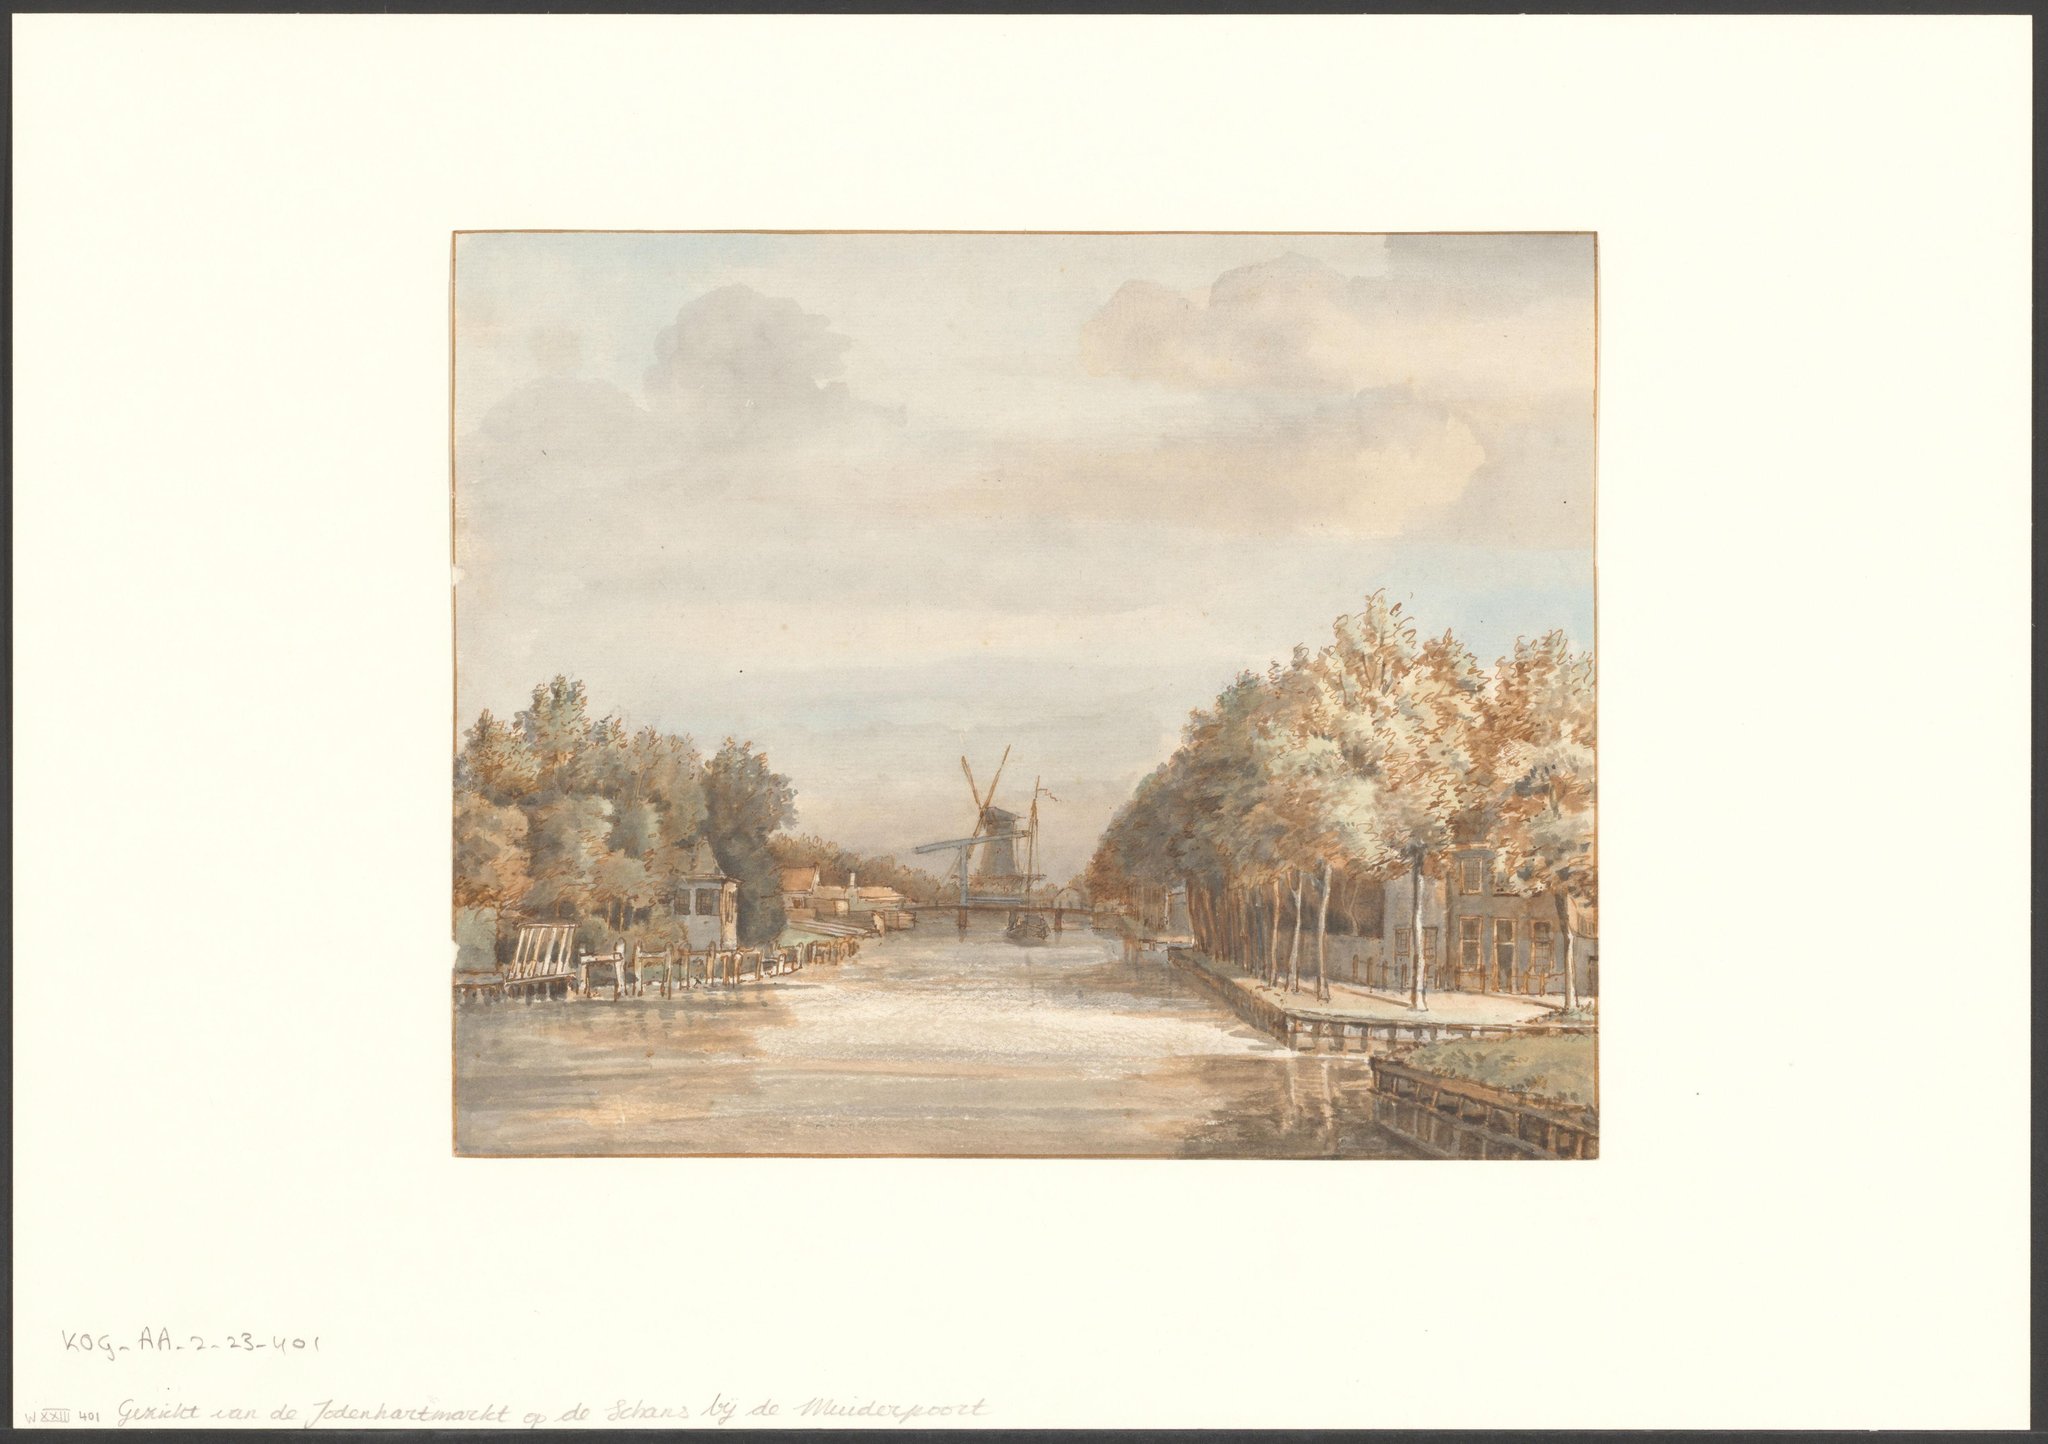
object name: drawing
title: Gezicht op de Jodenhoutmarkt op de schans bij de Muiderpoort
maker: gerrit lamberts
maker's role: bookseller, draughtsman, print maker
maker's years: 1776-1850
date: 1818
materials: ink, paper, watercolor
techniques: brush, pen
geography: amsterdam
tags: city-view in general; 'veduta', canal, bridge in city across river, canal, etc., windmill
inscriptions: collector's mark: Lugt 800a, inscription: ‘Gezigt van de Joode Houtmarkt / op de schans bij de muiderpoort’, signature and date: ‘G. Lamberts 1818.’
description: Tekening binnen de Atlas Van Eck ingedeeld op wijknummer 23.